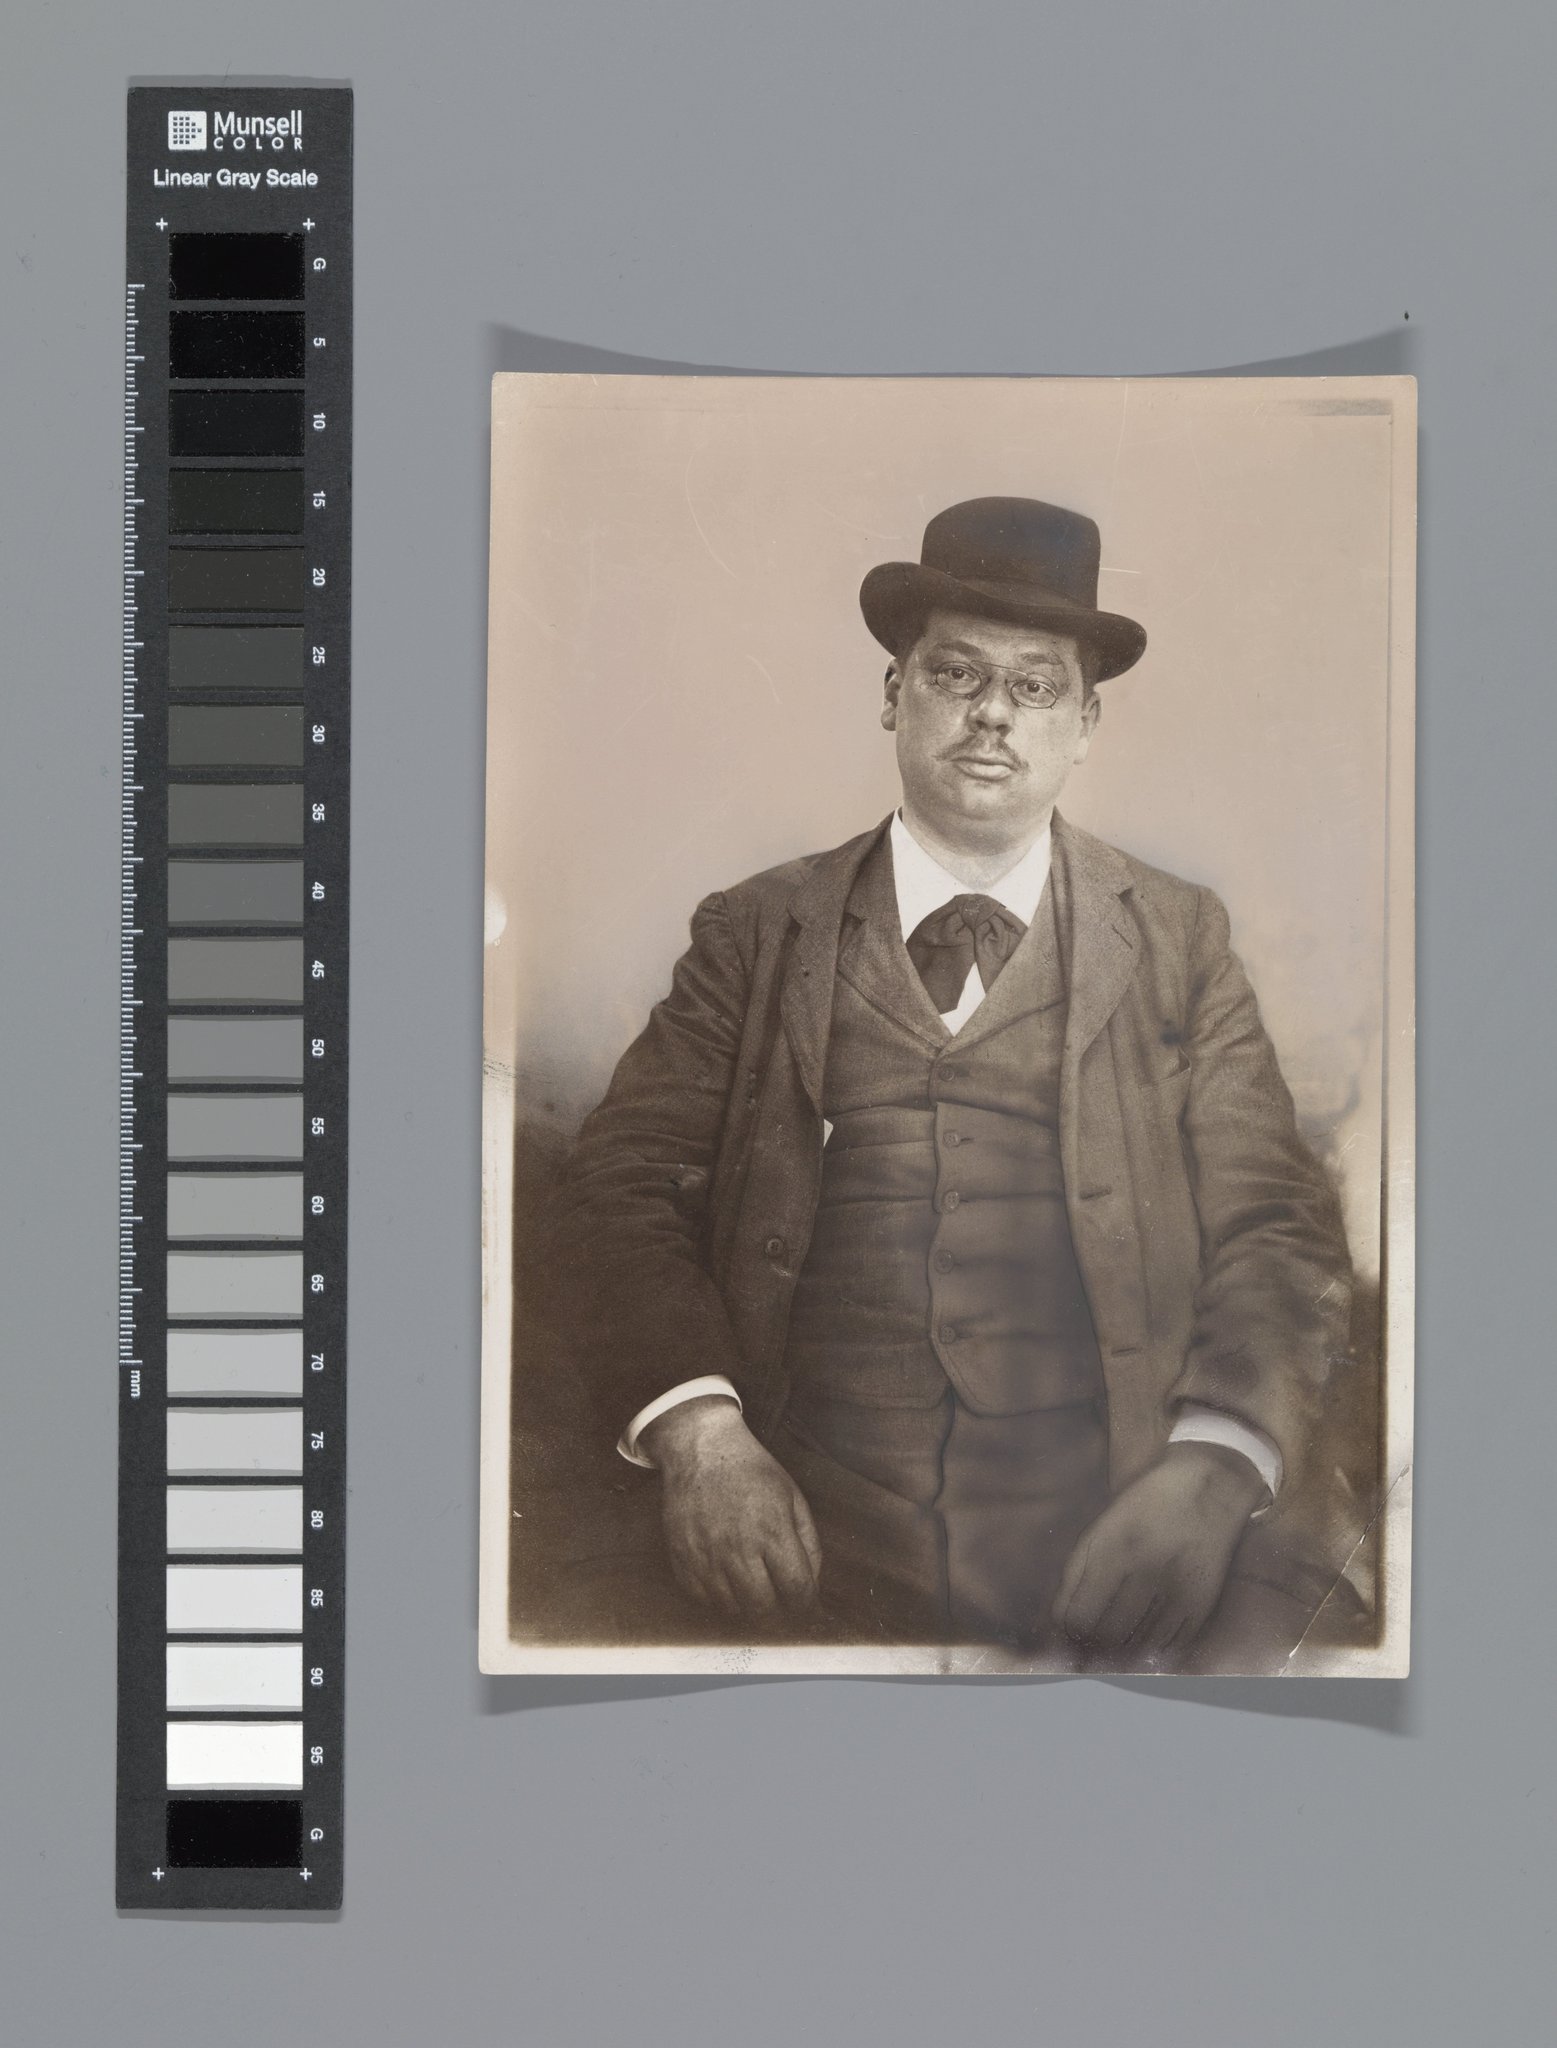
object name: photograph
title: Arnold Ising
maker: willem witsen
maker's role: draughtsman, painter, print maker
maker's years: 1860-1923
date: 1860-1915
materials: paper, photographic support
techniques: gelatin silver print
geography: amsterdam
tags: the hague, arnold paul constant ising